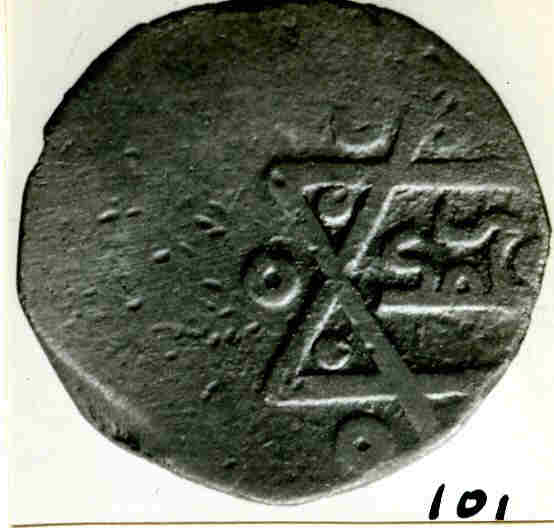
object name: coin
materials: copper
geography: iran